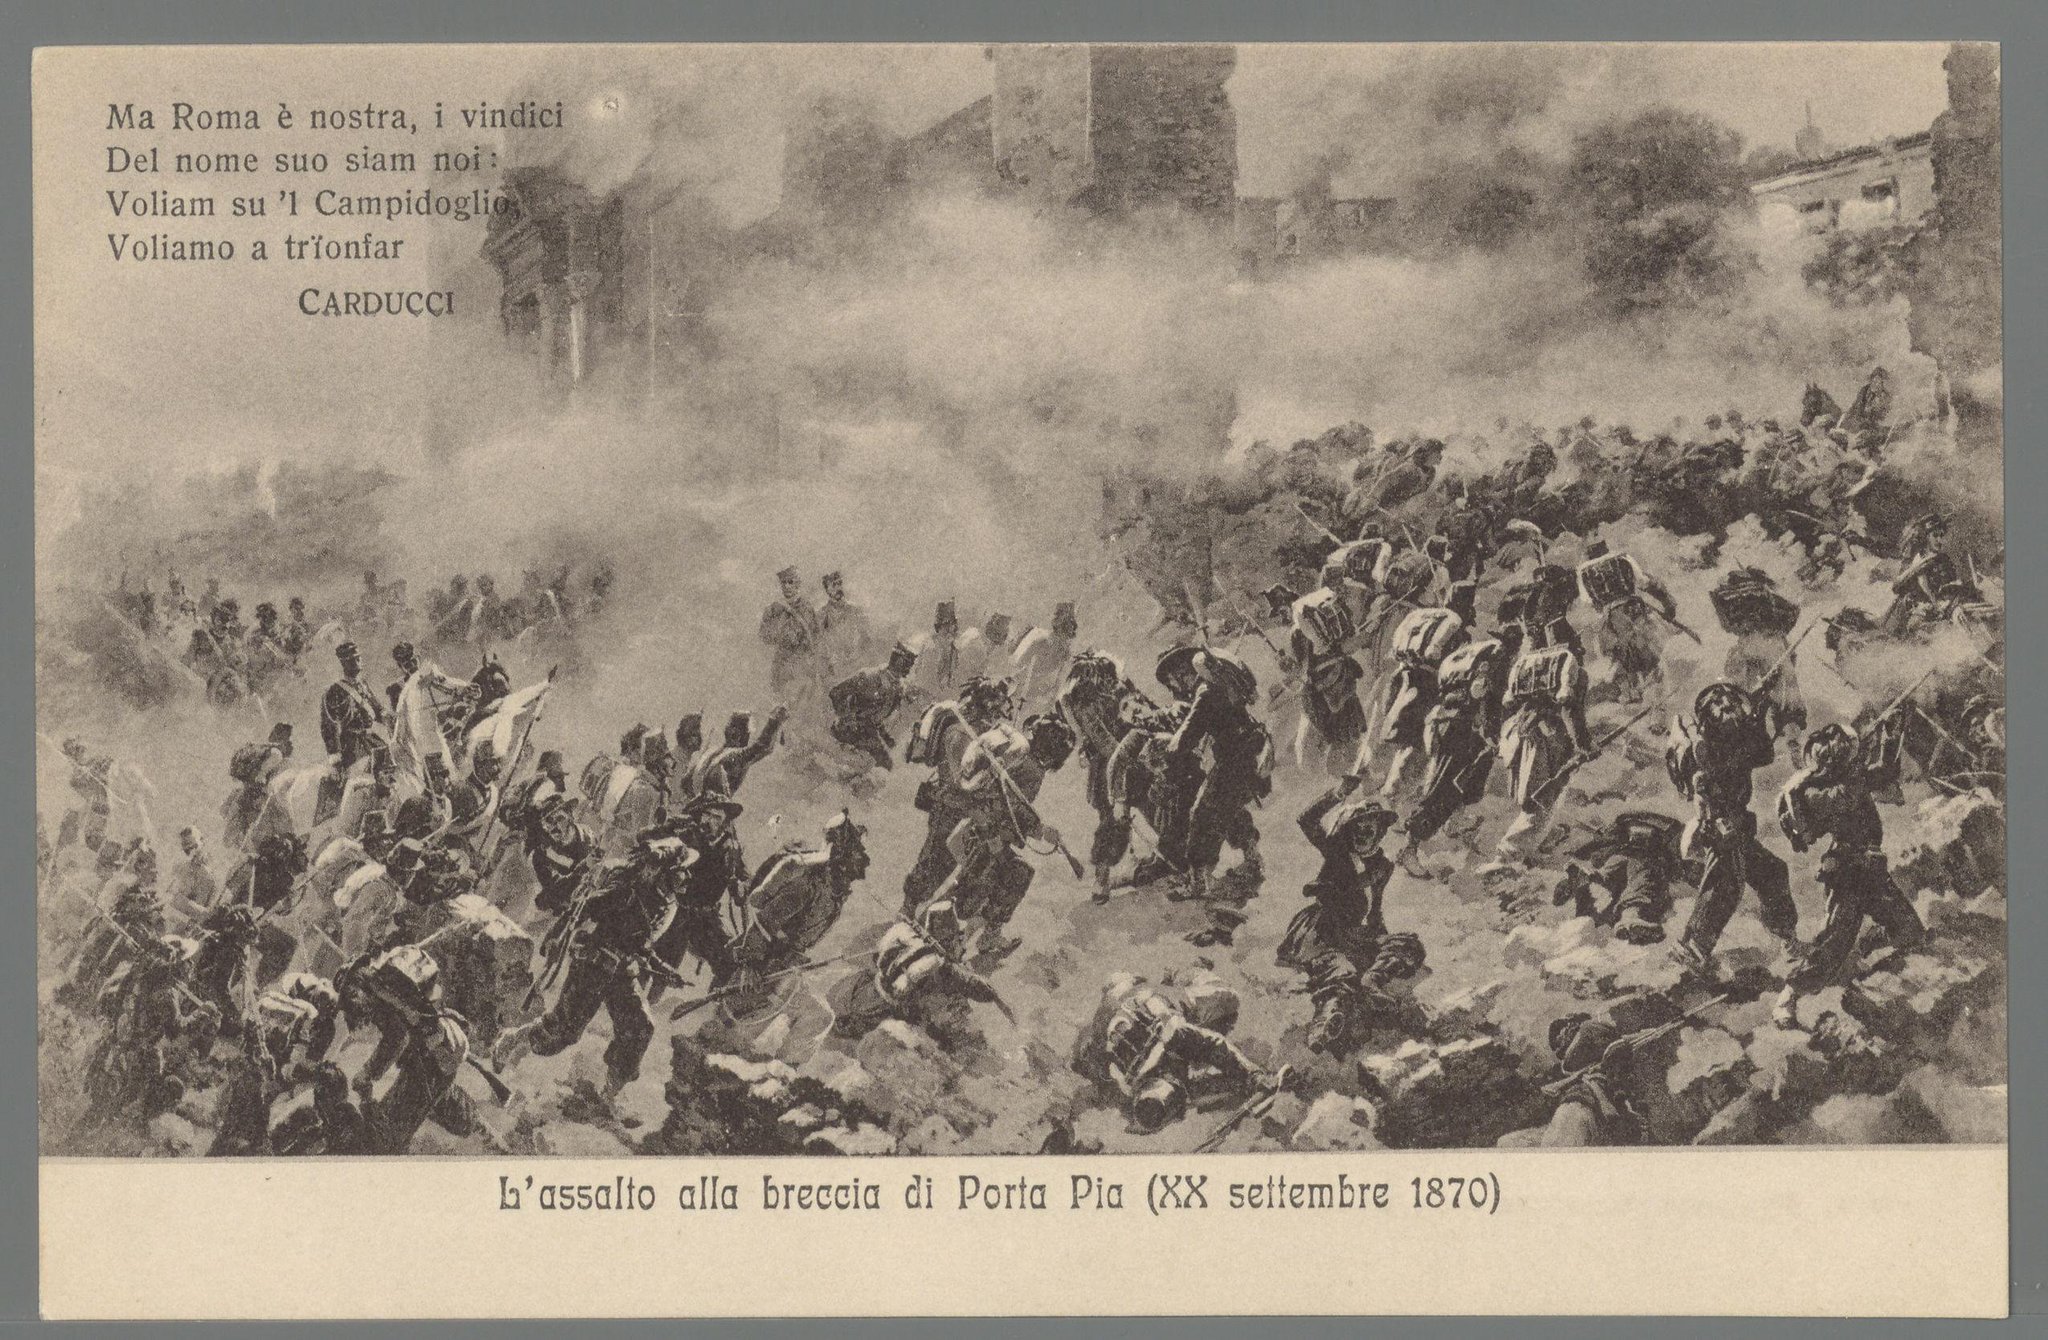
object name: photomechanical print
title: L'assalto alla breccia di Porta Pia (XX settembre 1870)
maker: Anonymous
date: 1906-1910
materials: cardboard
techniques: photograph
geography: terni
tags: battle, city-gate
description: Voorstelling van de verovering van Rome in de strijd rond de eenwording van Italië. Linksboven een gedicht van Carducci.